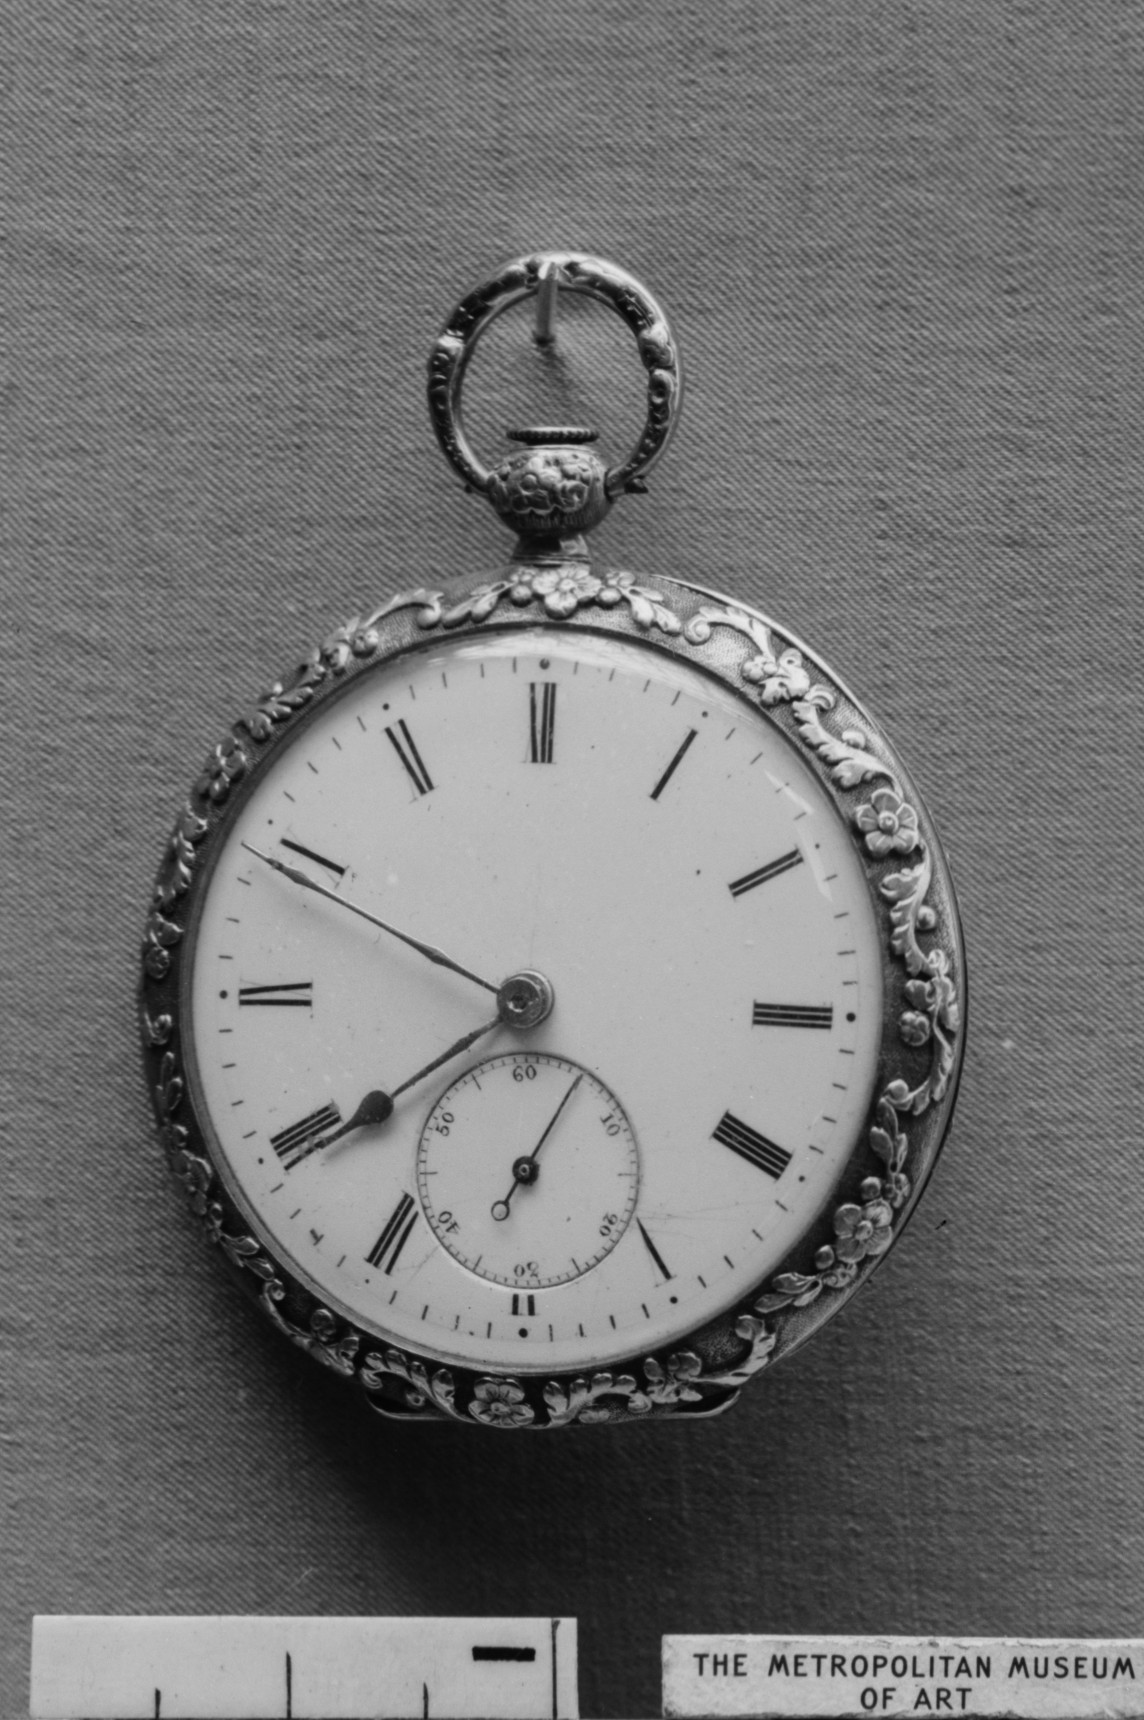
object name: pocket watch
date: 1801-1833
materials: enamel, gold